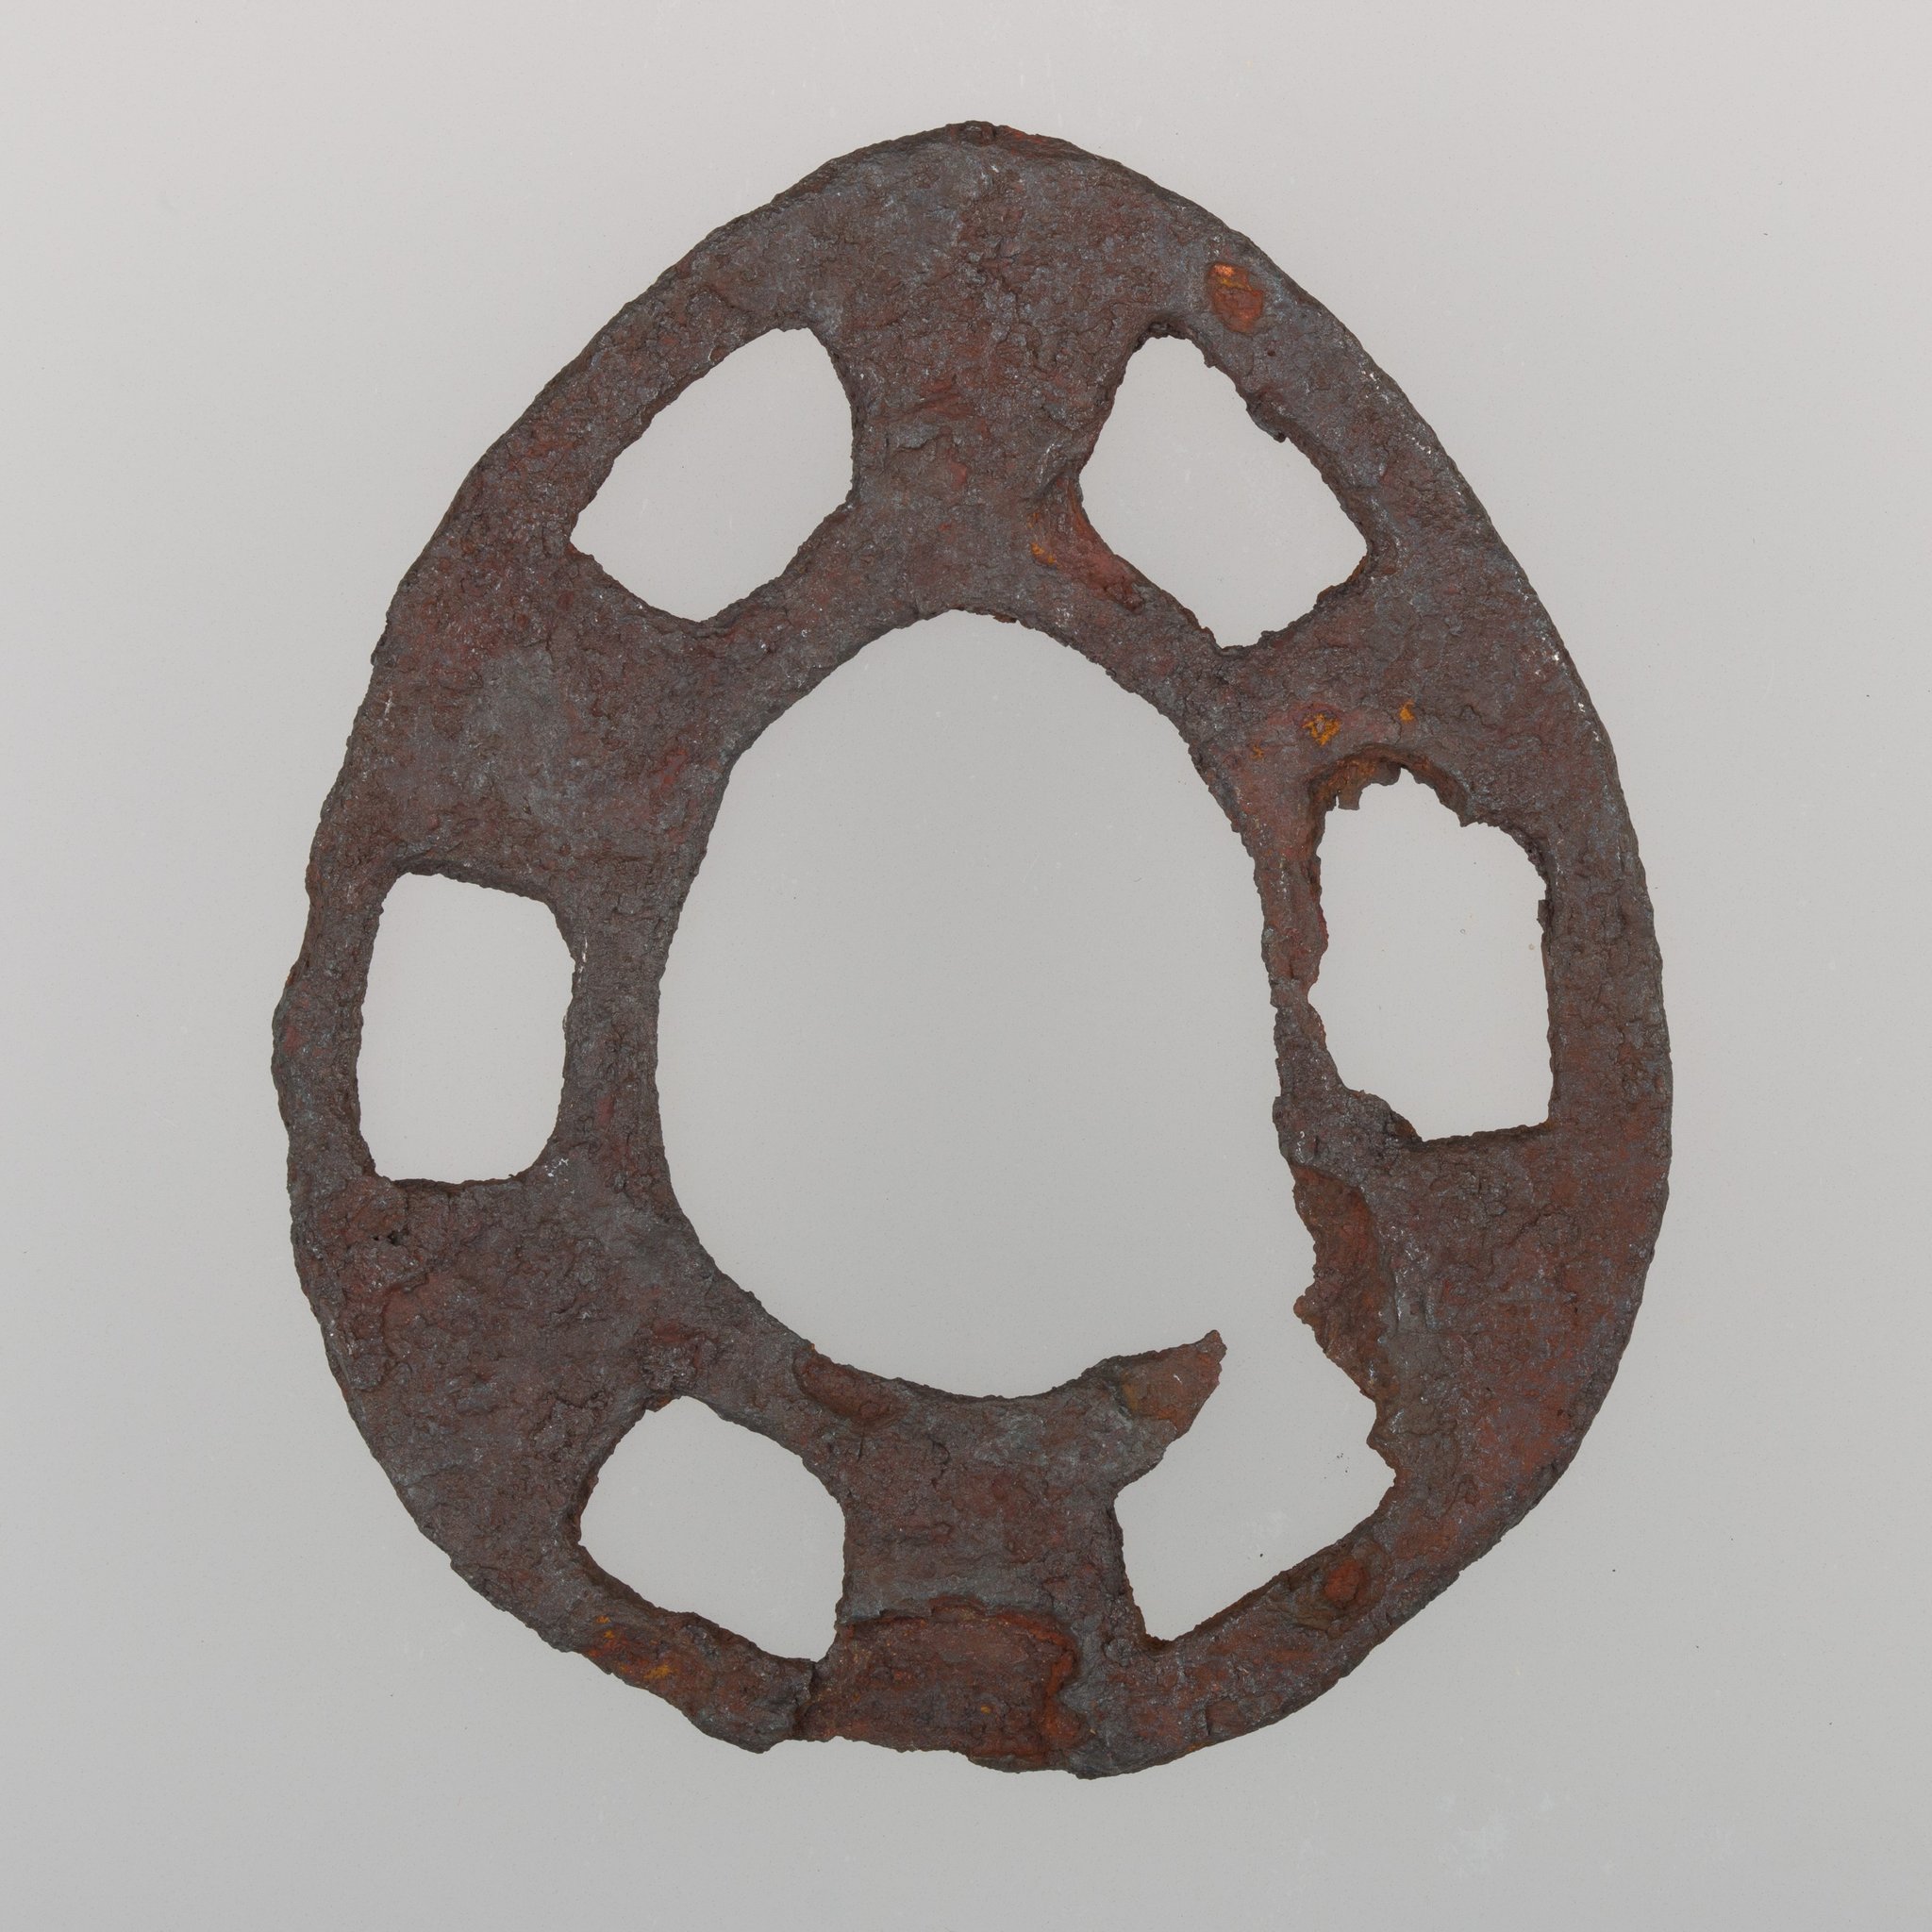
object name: sword guard tsuba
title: Sword Guard (Tsuba)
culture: japanese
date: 201-300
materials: iron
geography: japan